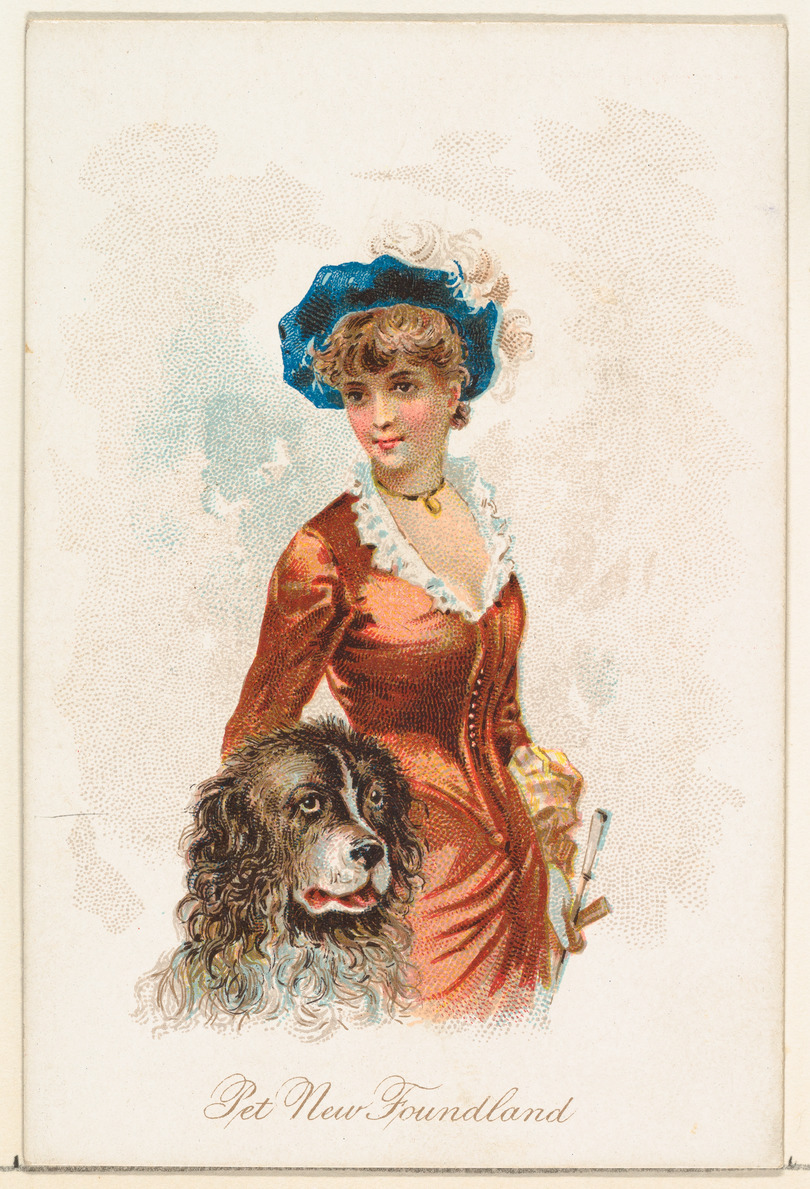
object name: print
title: Pet Newfoundland, from the Household Pets series (N194) issued by Wm. S. Kimball & Co.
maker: william s. kimball & company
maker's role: publisher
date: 1891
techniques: color lithograph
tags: women,dogs